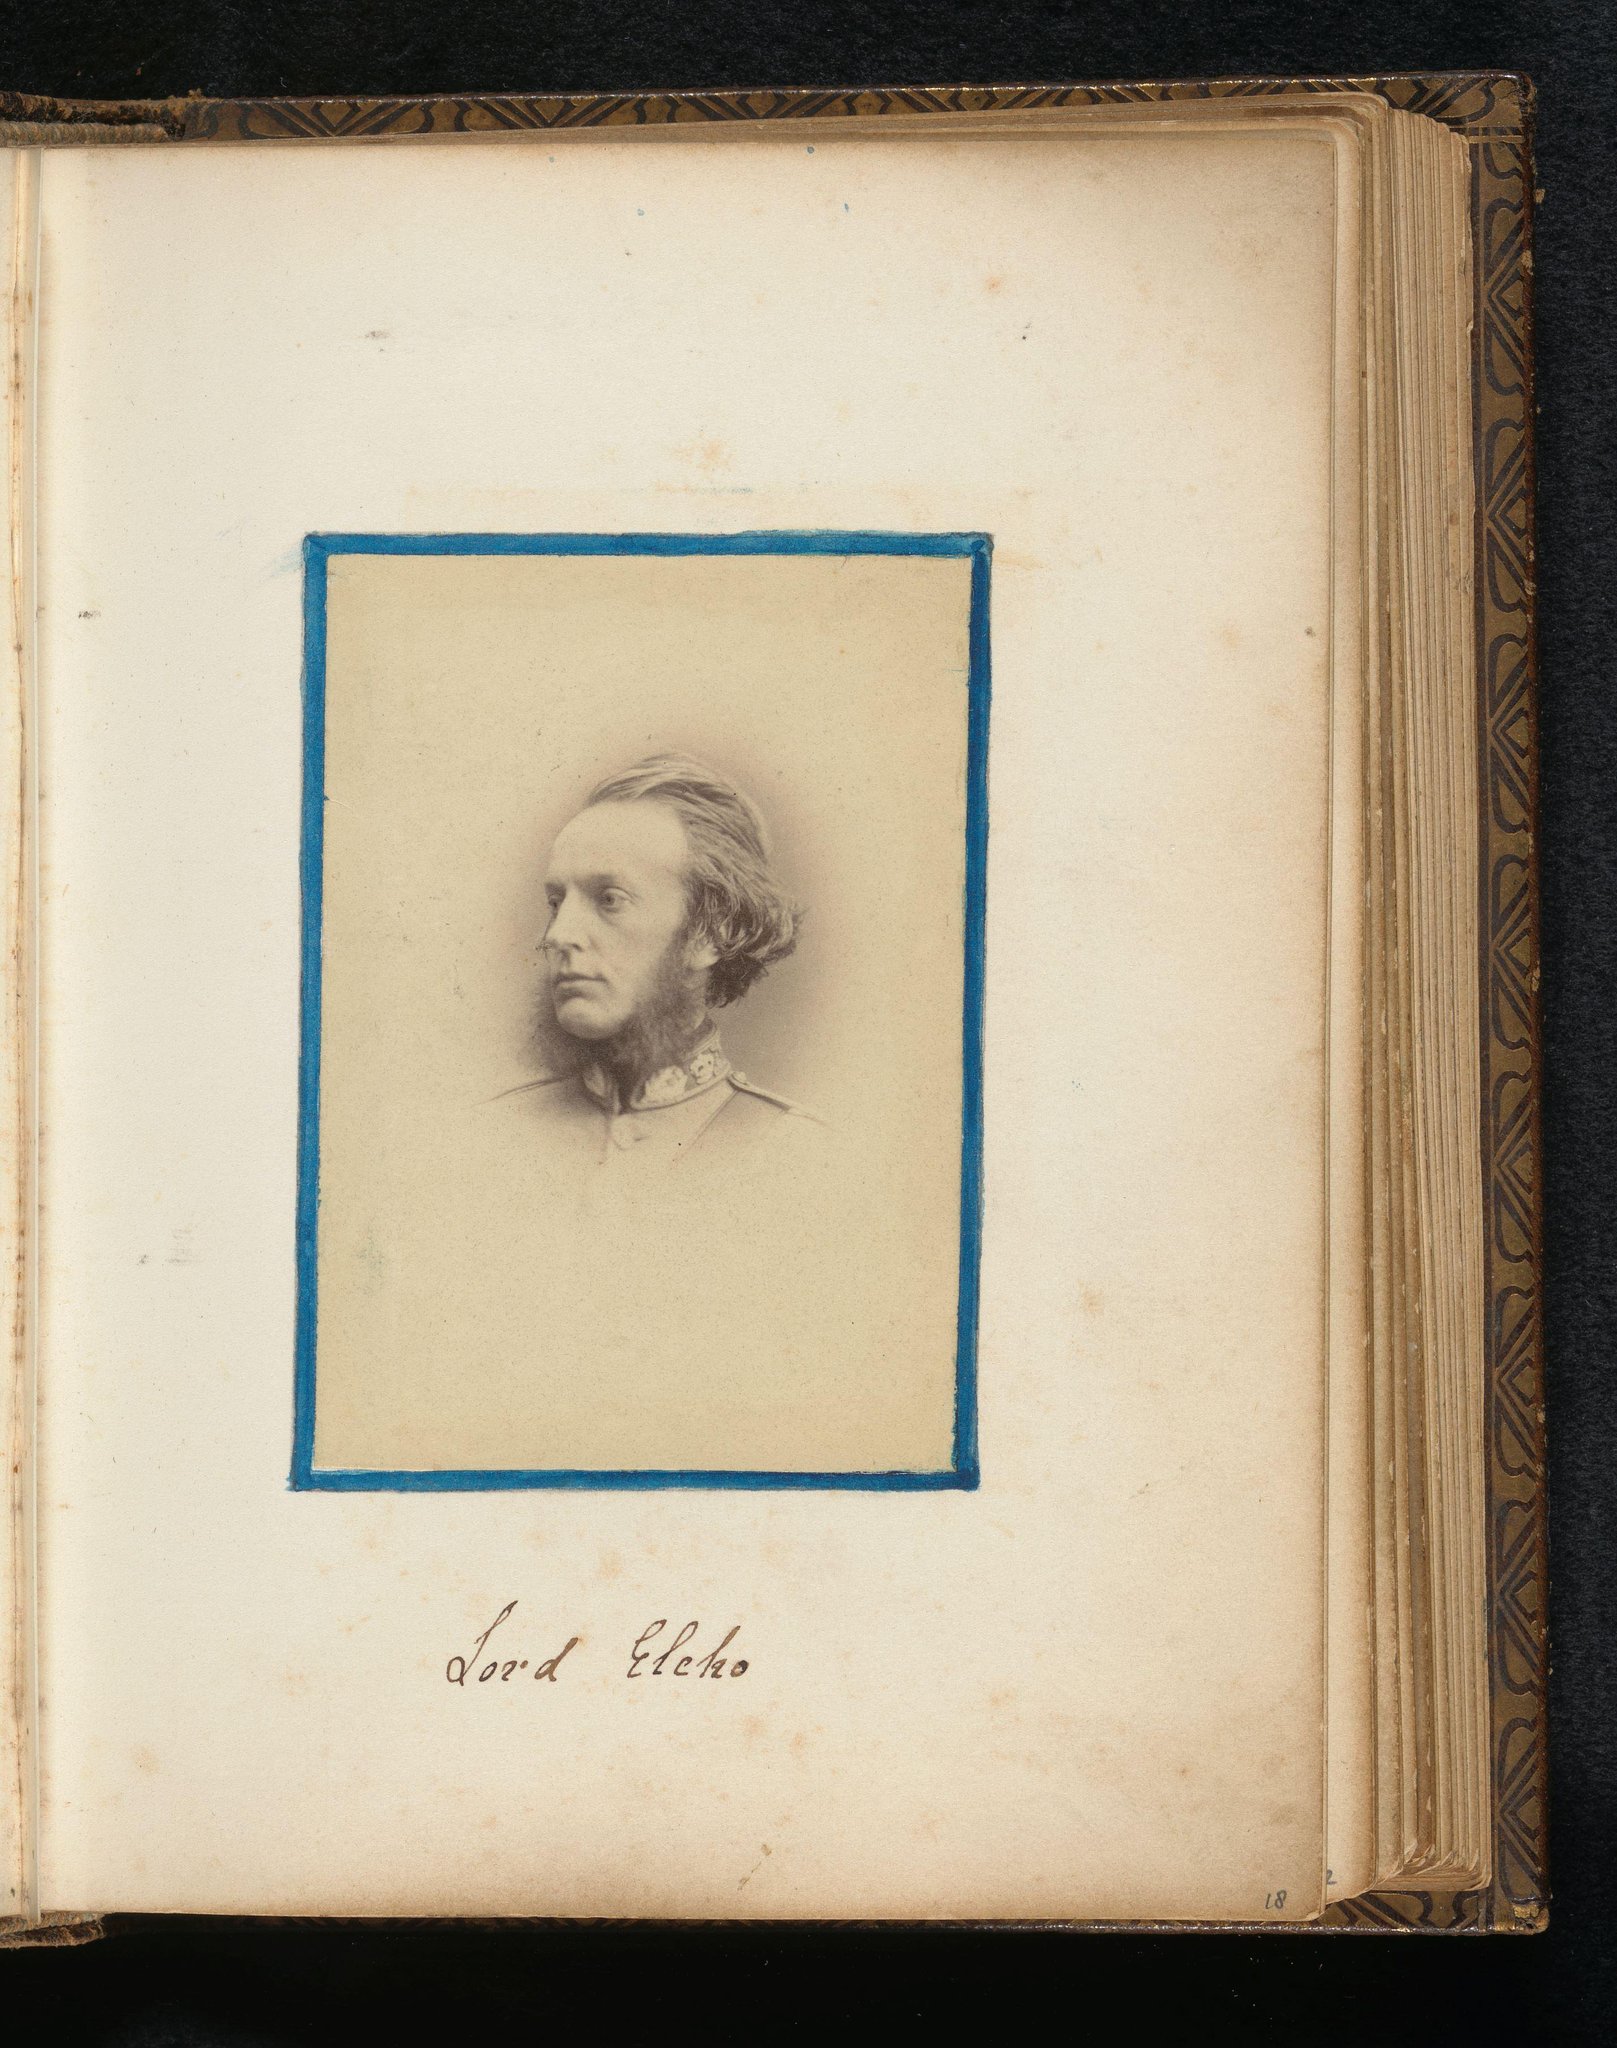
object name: photograph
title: Portret van Lord Elcho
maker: Anonymous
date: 1865-1867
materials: cardboard, photographic support, watercolor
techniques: albumen print, aquarelle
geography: england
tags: historical persons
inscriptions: annotation: ‘Lord Elcho’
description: Portret van de Britse politicus Francis Richard Charteris, 10th Earl of Wemyss, Lord Elcho. Foto op albumblad in album met 68 foto's merendeels met geaquarelleerde randversieringen. Het zijn voornamelijk portretten op carte-de-visite formaat.